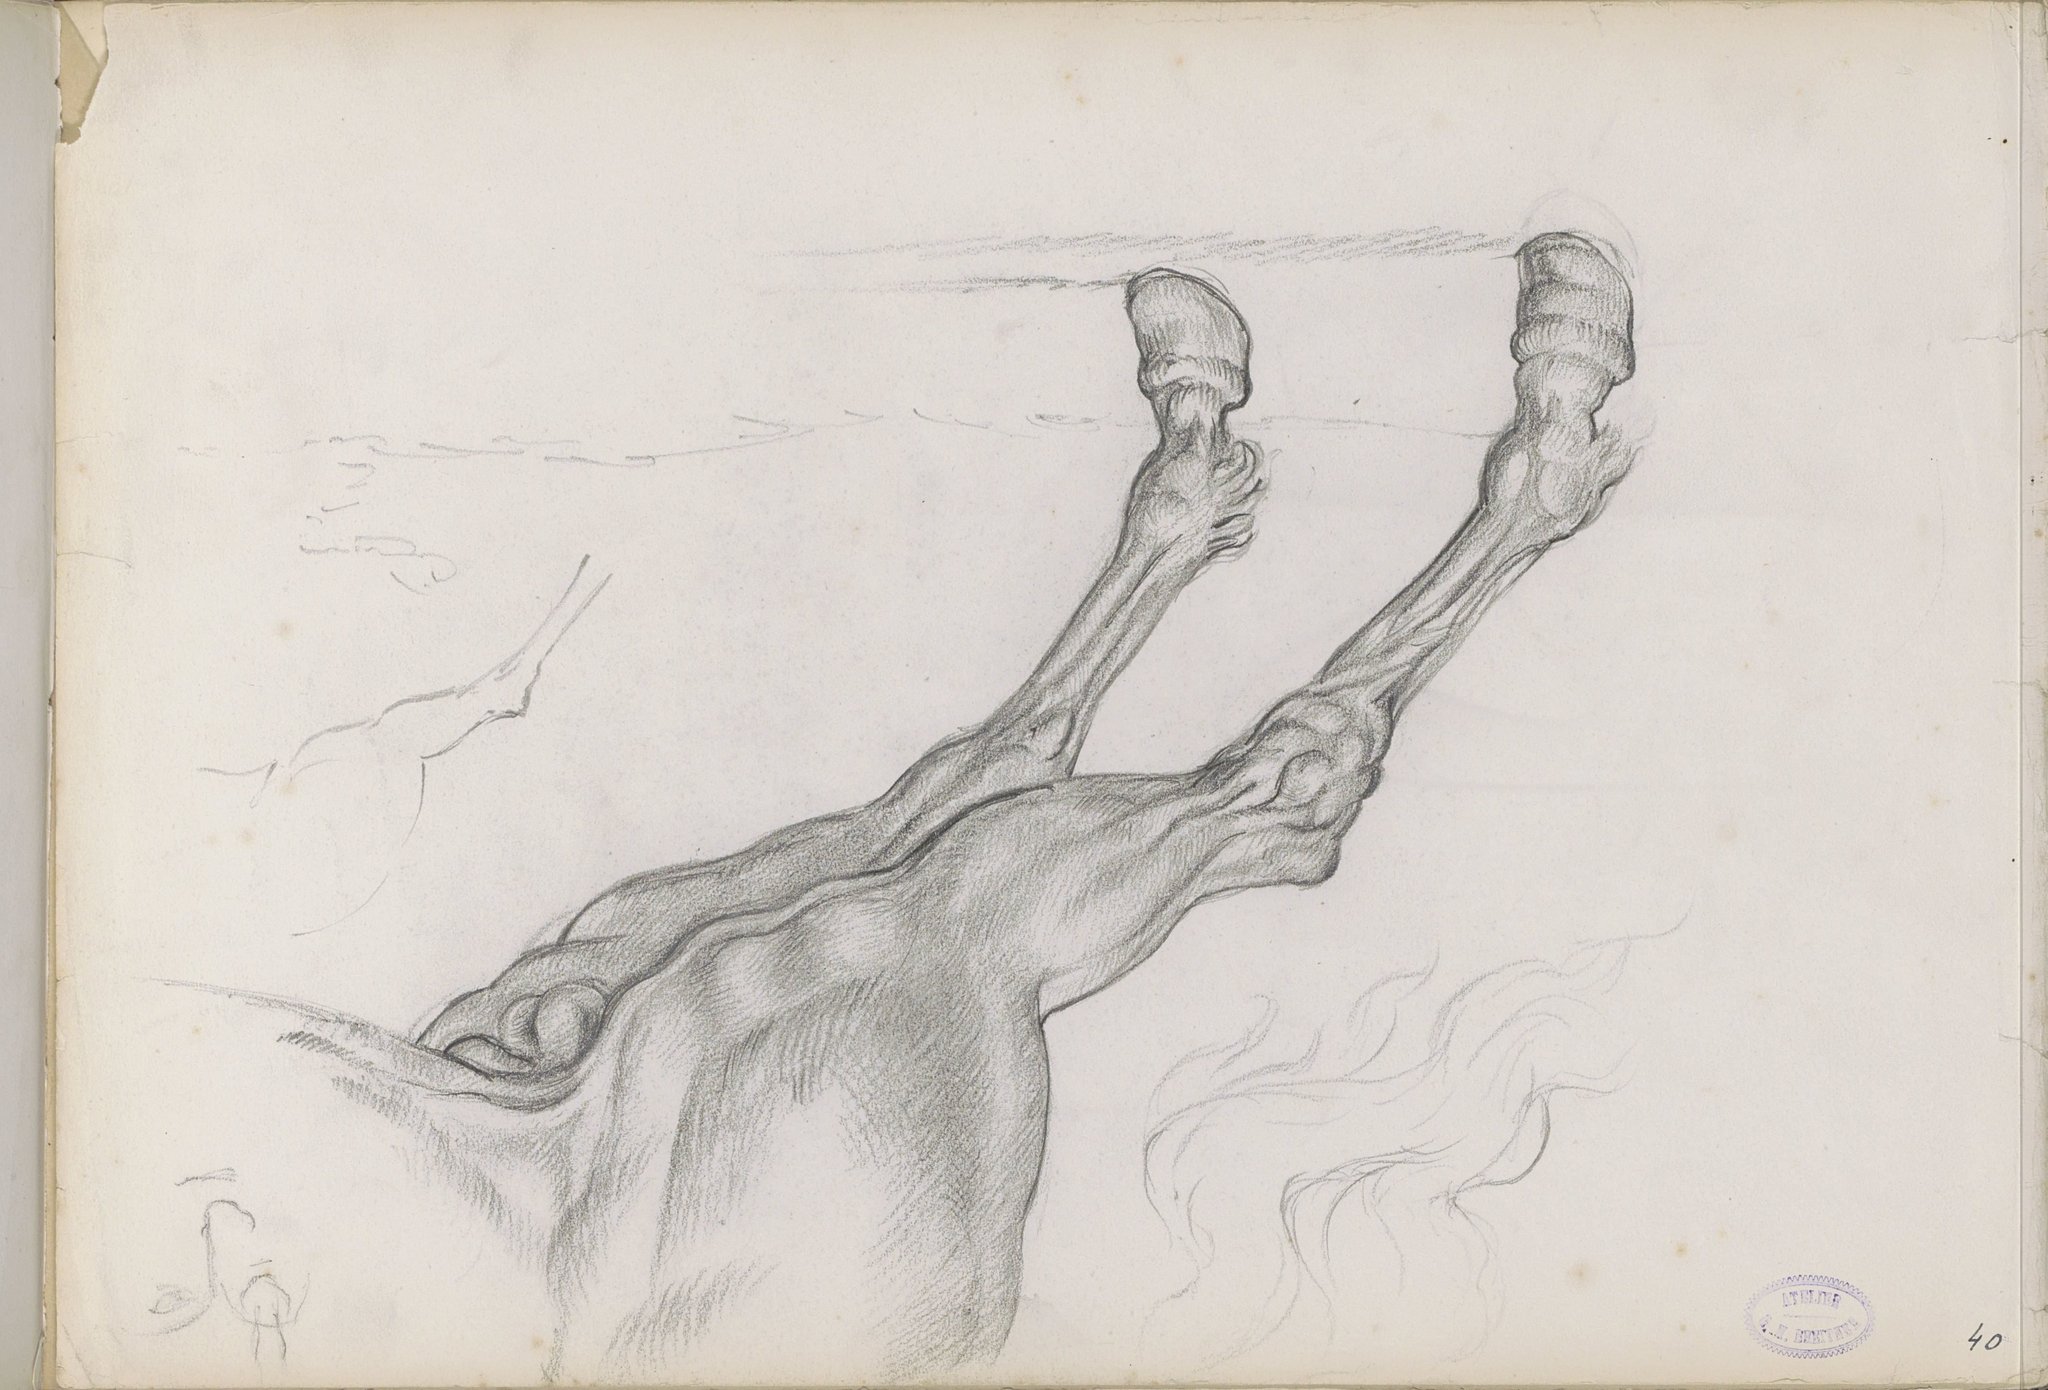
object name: sketchbook leaf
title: Onderlijf van een paard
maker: george hendrik breitner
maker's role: draughtsman, painter, print maker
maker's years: 1857-1923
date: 1873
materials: paper, pencil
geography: rotterdam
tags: horse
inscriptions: workshop stamp: Lugt 291d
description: Blad 40 recto uit een schetsboek met 25 bladen.